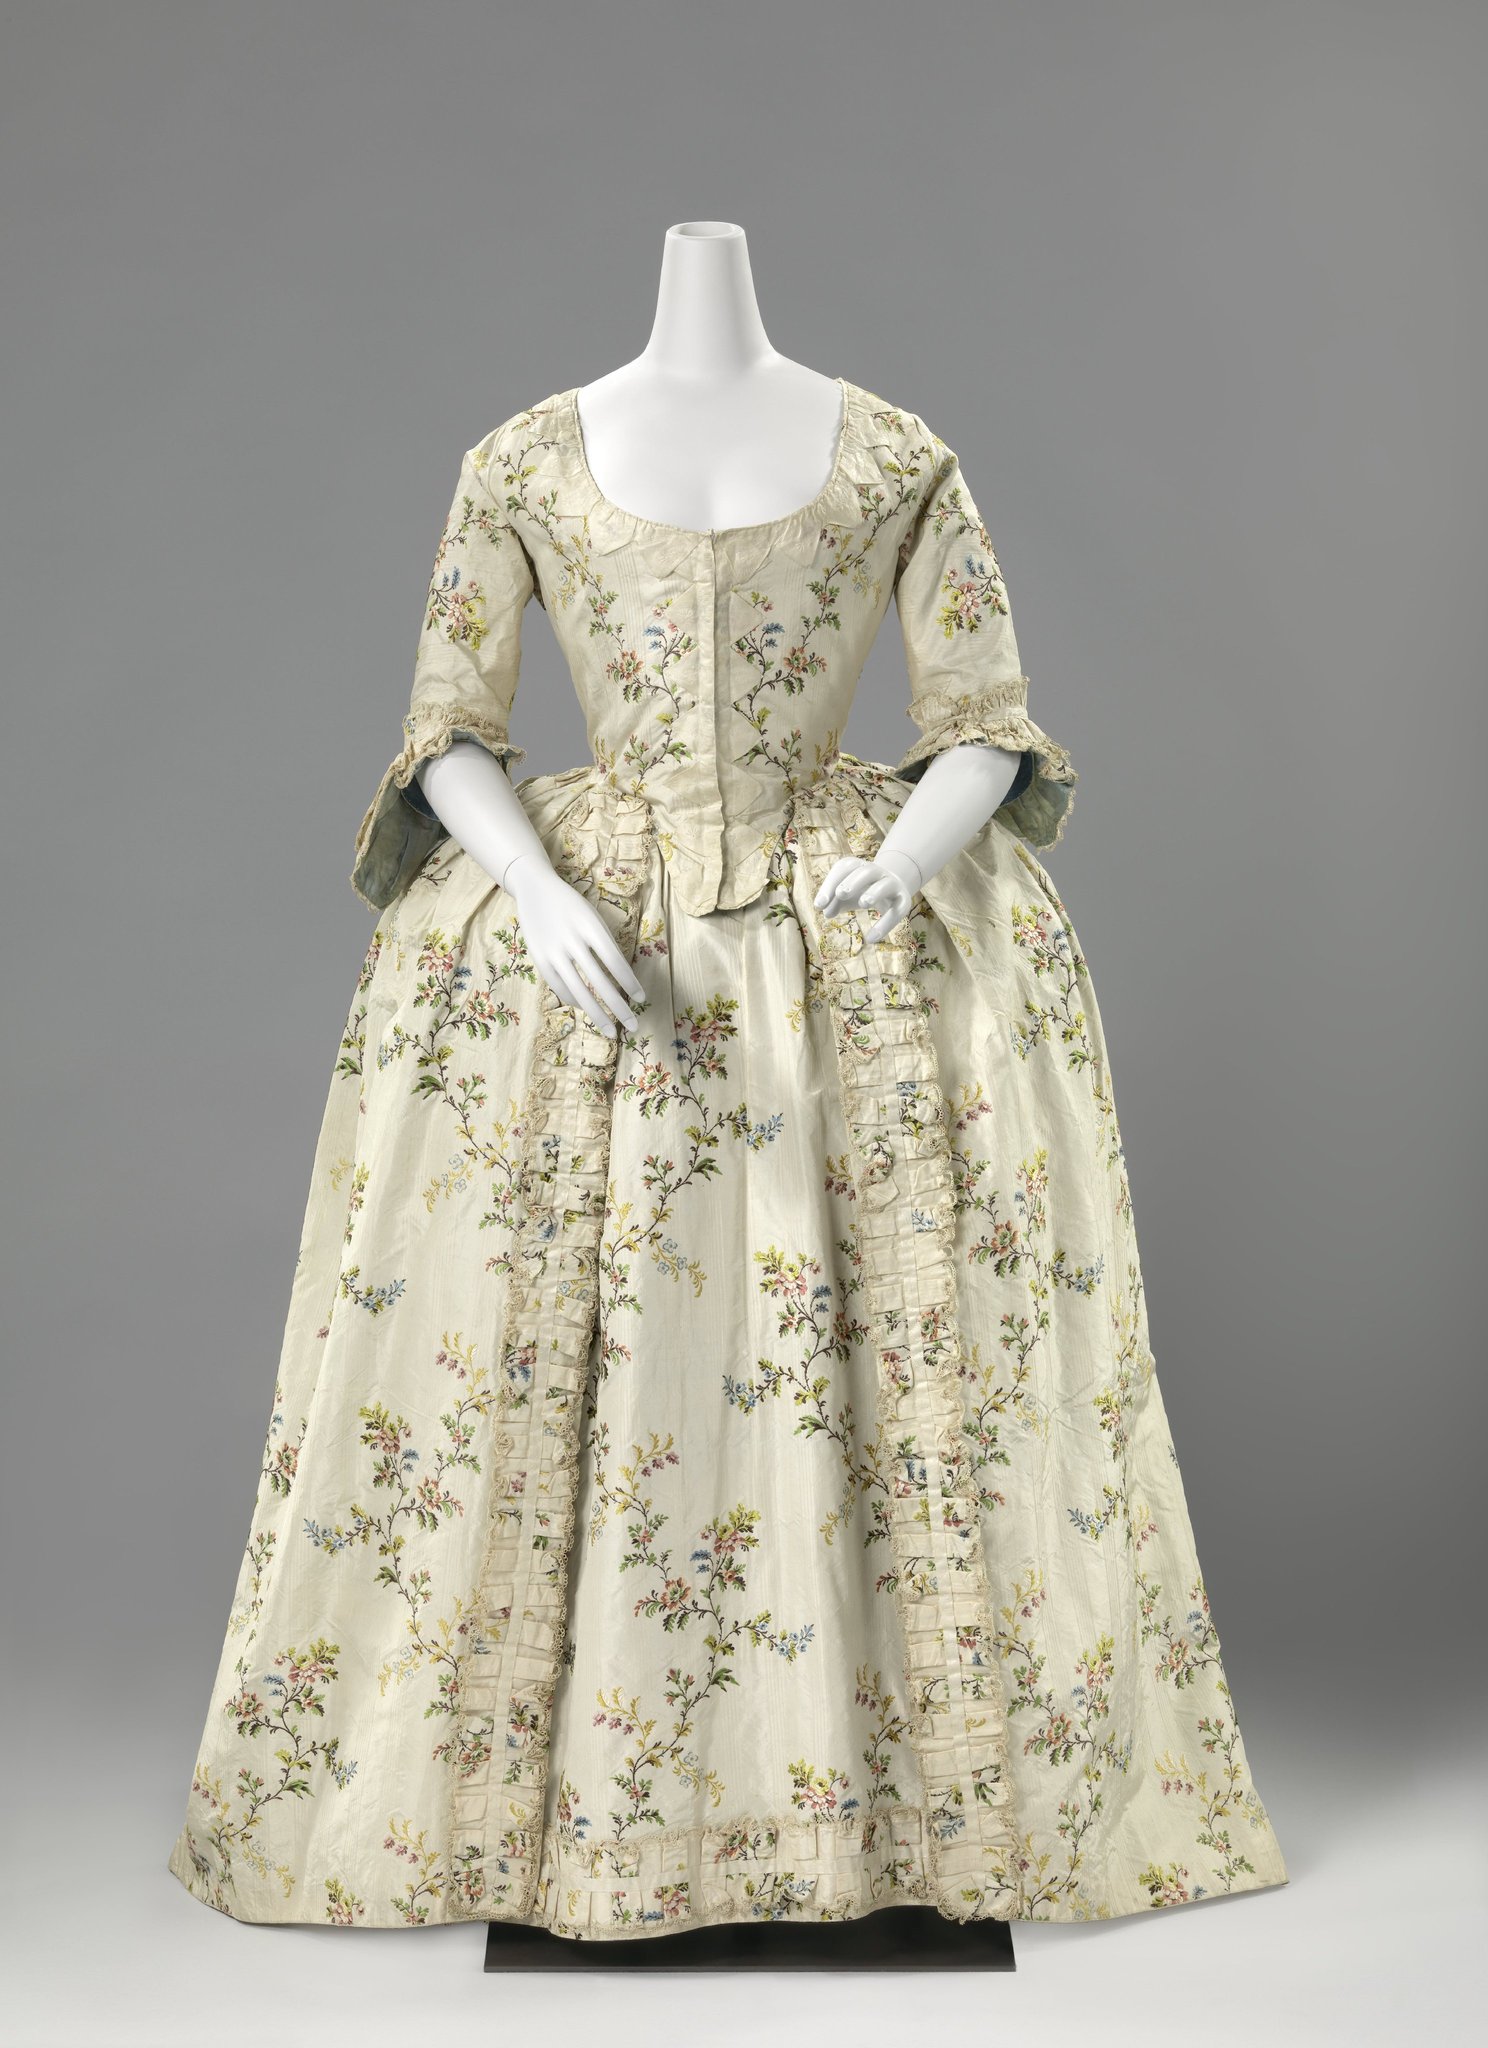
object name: wedding dress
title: Wedding dress of flowered silk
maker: Anonymous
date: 1760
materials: silk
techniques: brocade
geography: netherlands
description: In the 18th century brides wore dresses in light shades of blue, yellow, and pink or with fashionable woven or embroidered patterns. Only royal brides wore (silvery) white on their wedding day. This dress consists of a robe and a skirt, both embellished with ruffled flounces of the same material.